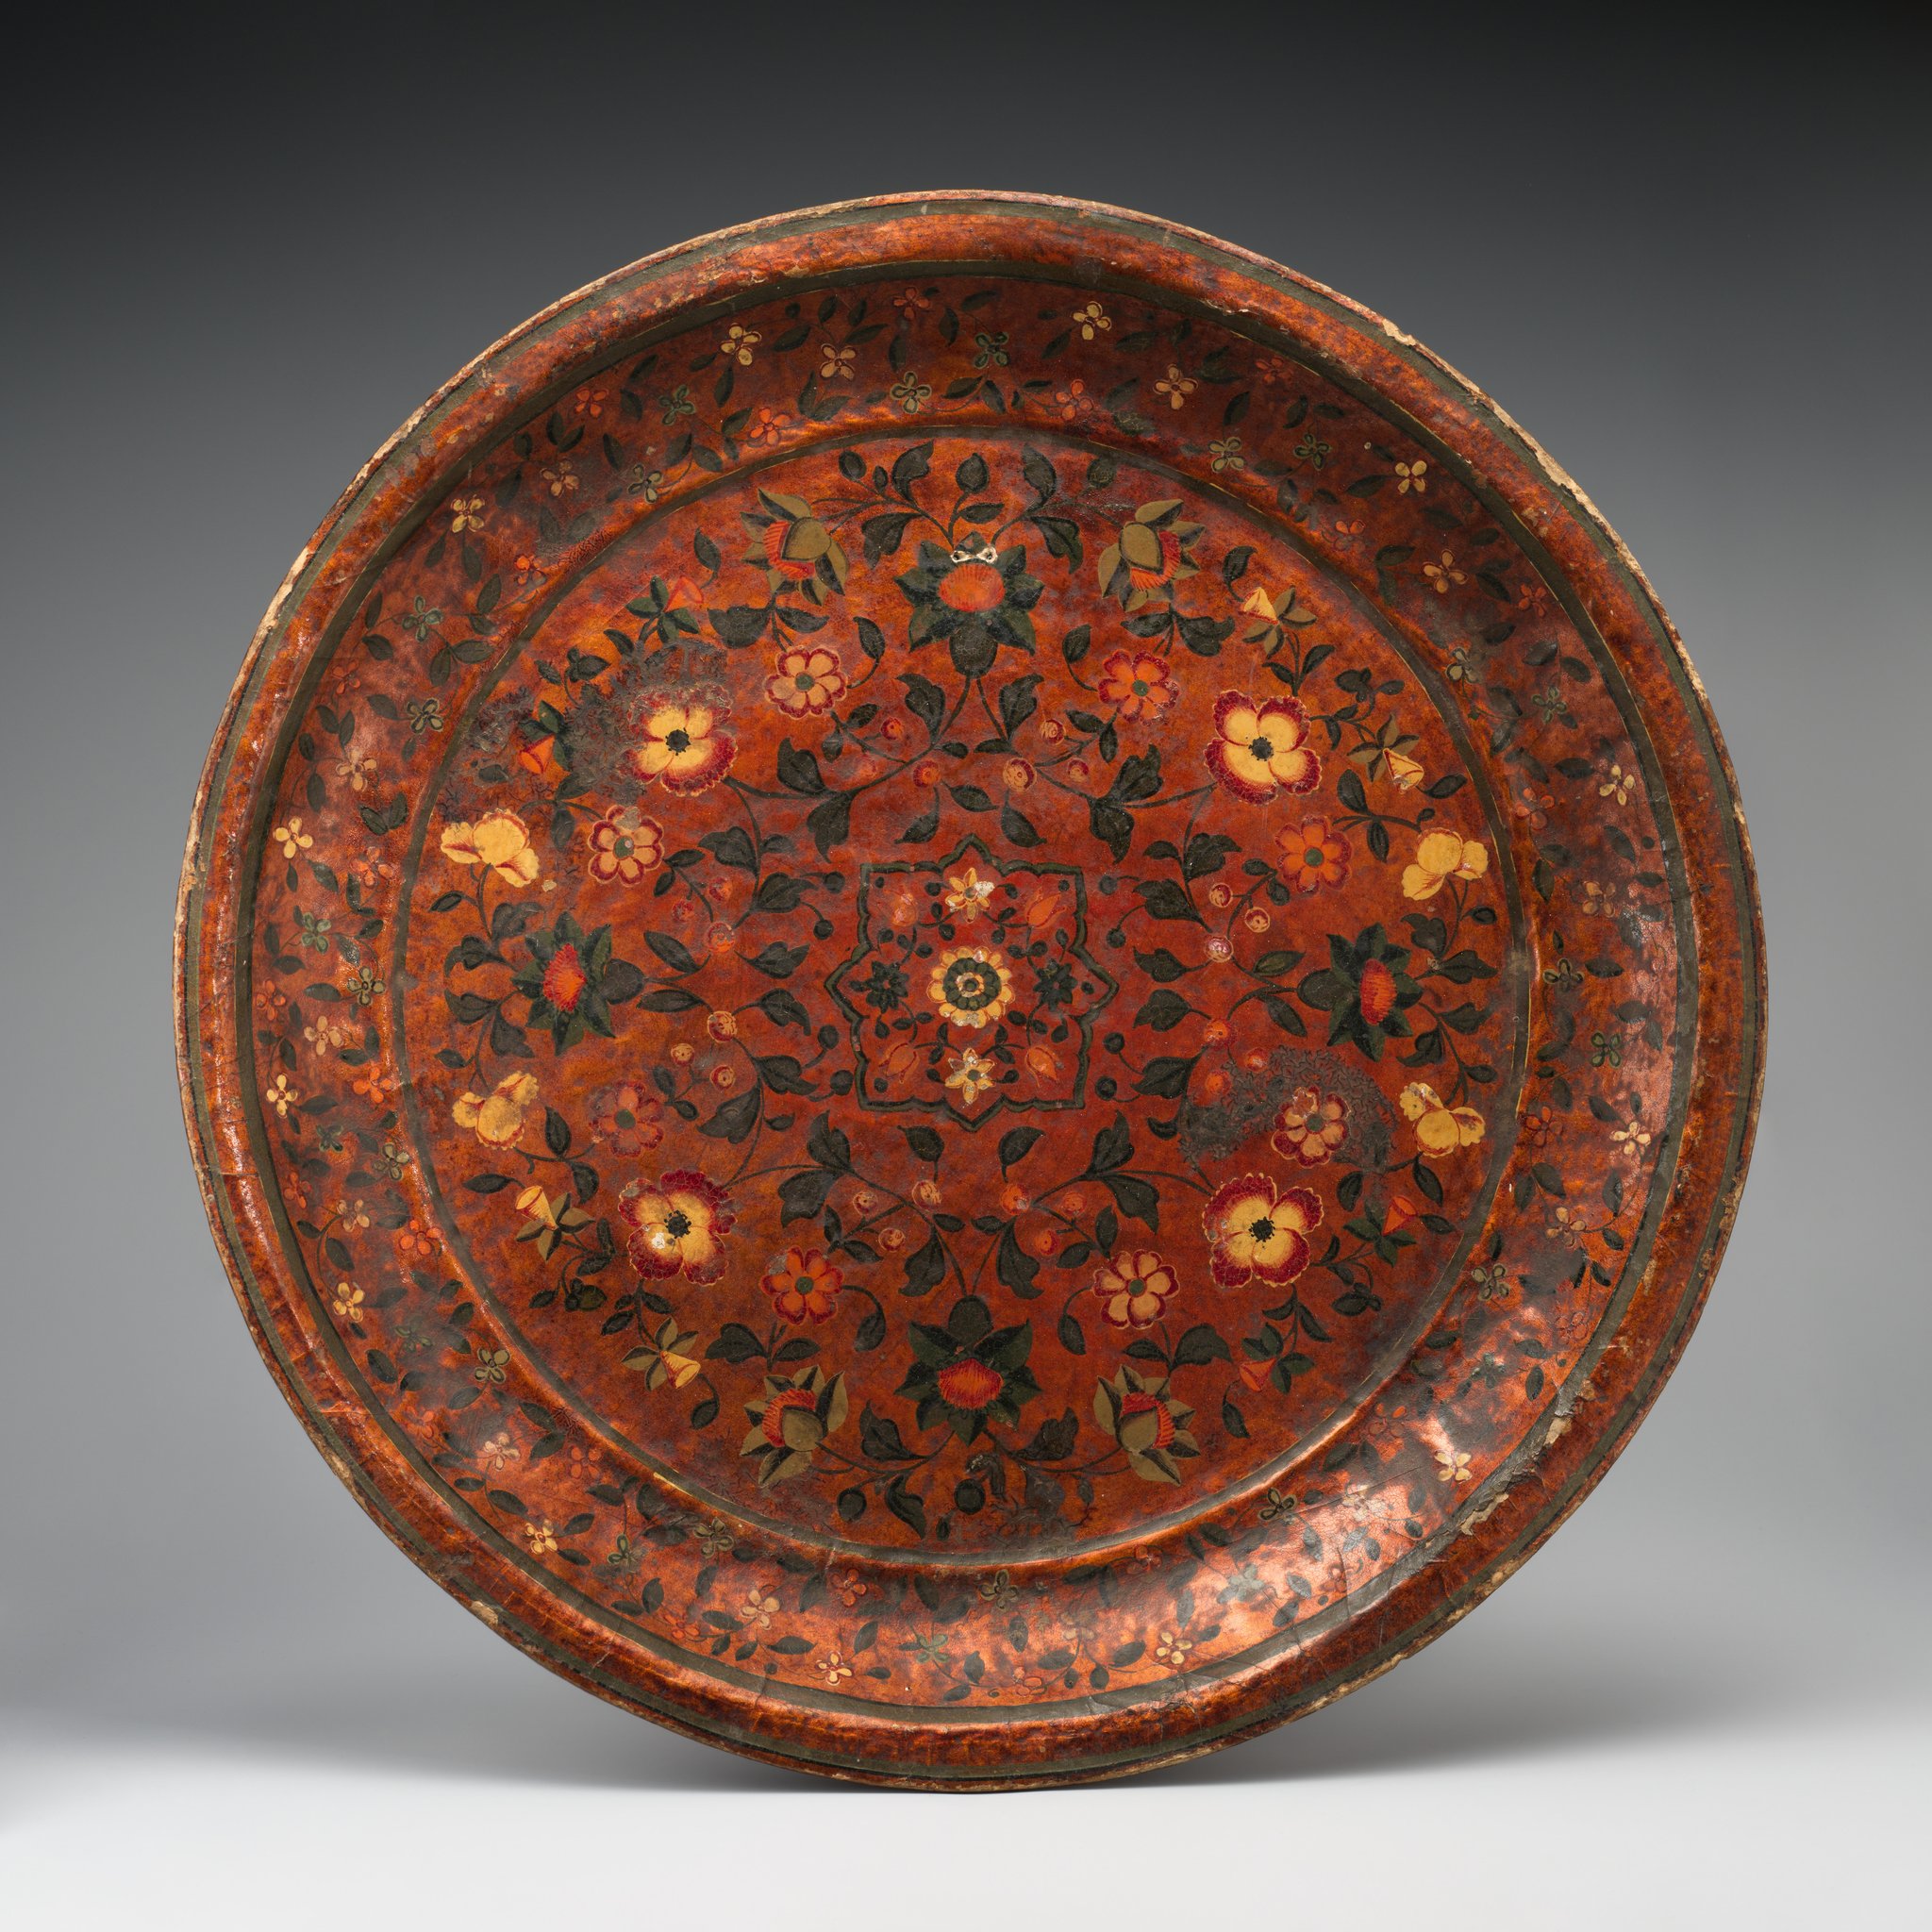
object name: plate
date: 1801-1900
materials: paper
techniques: lacquer, painting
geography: iran